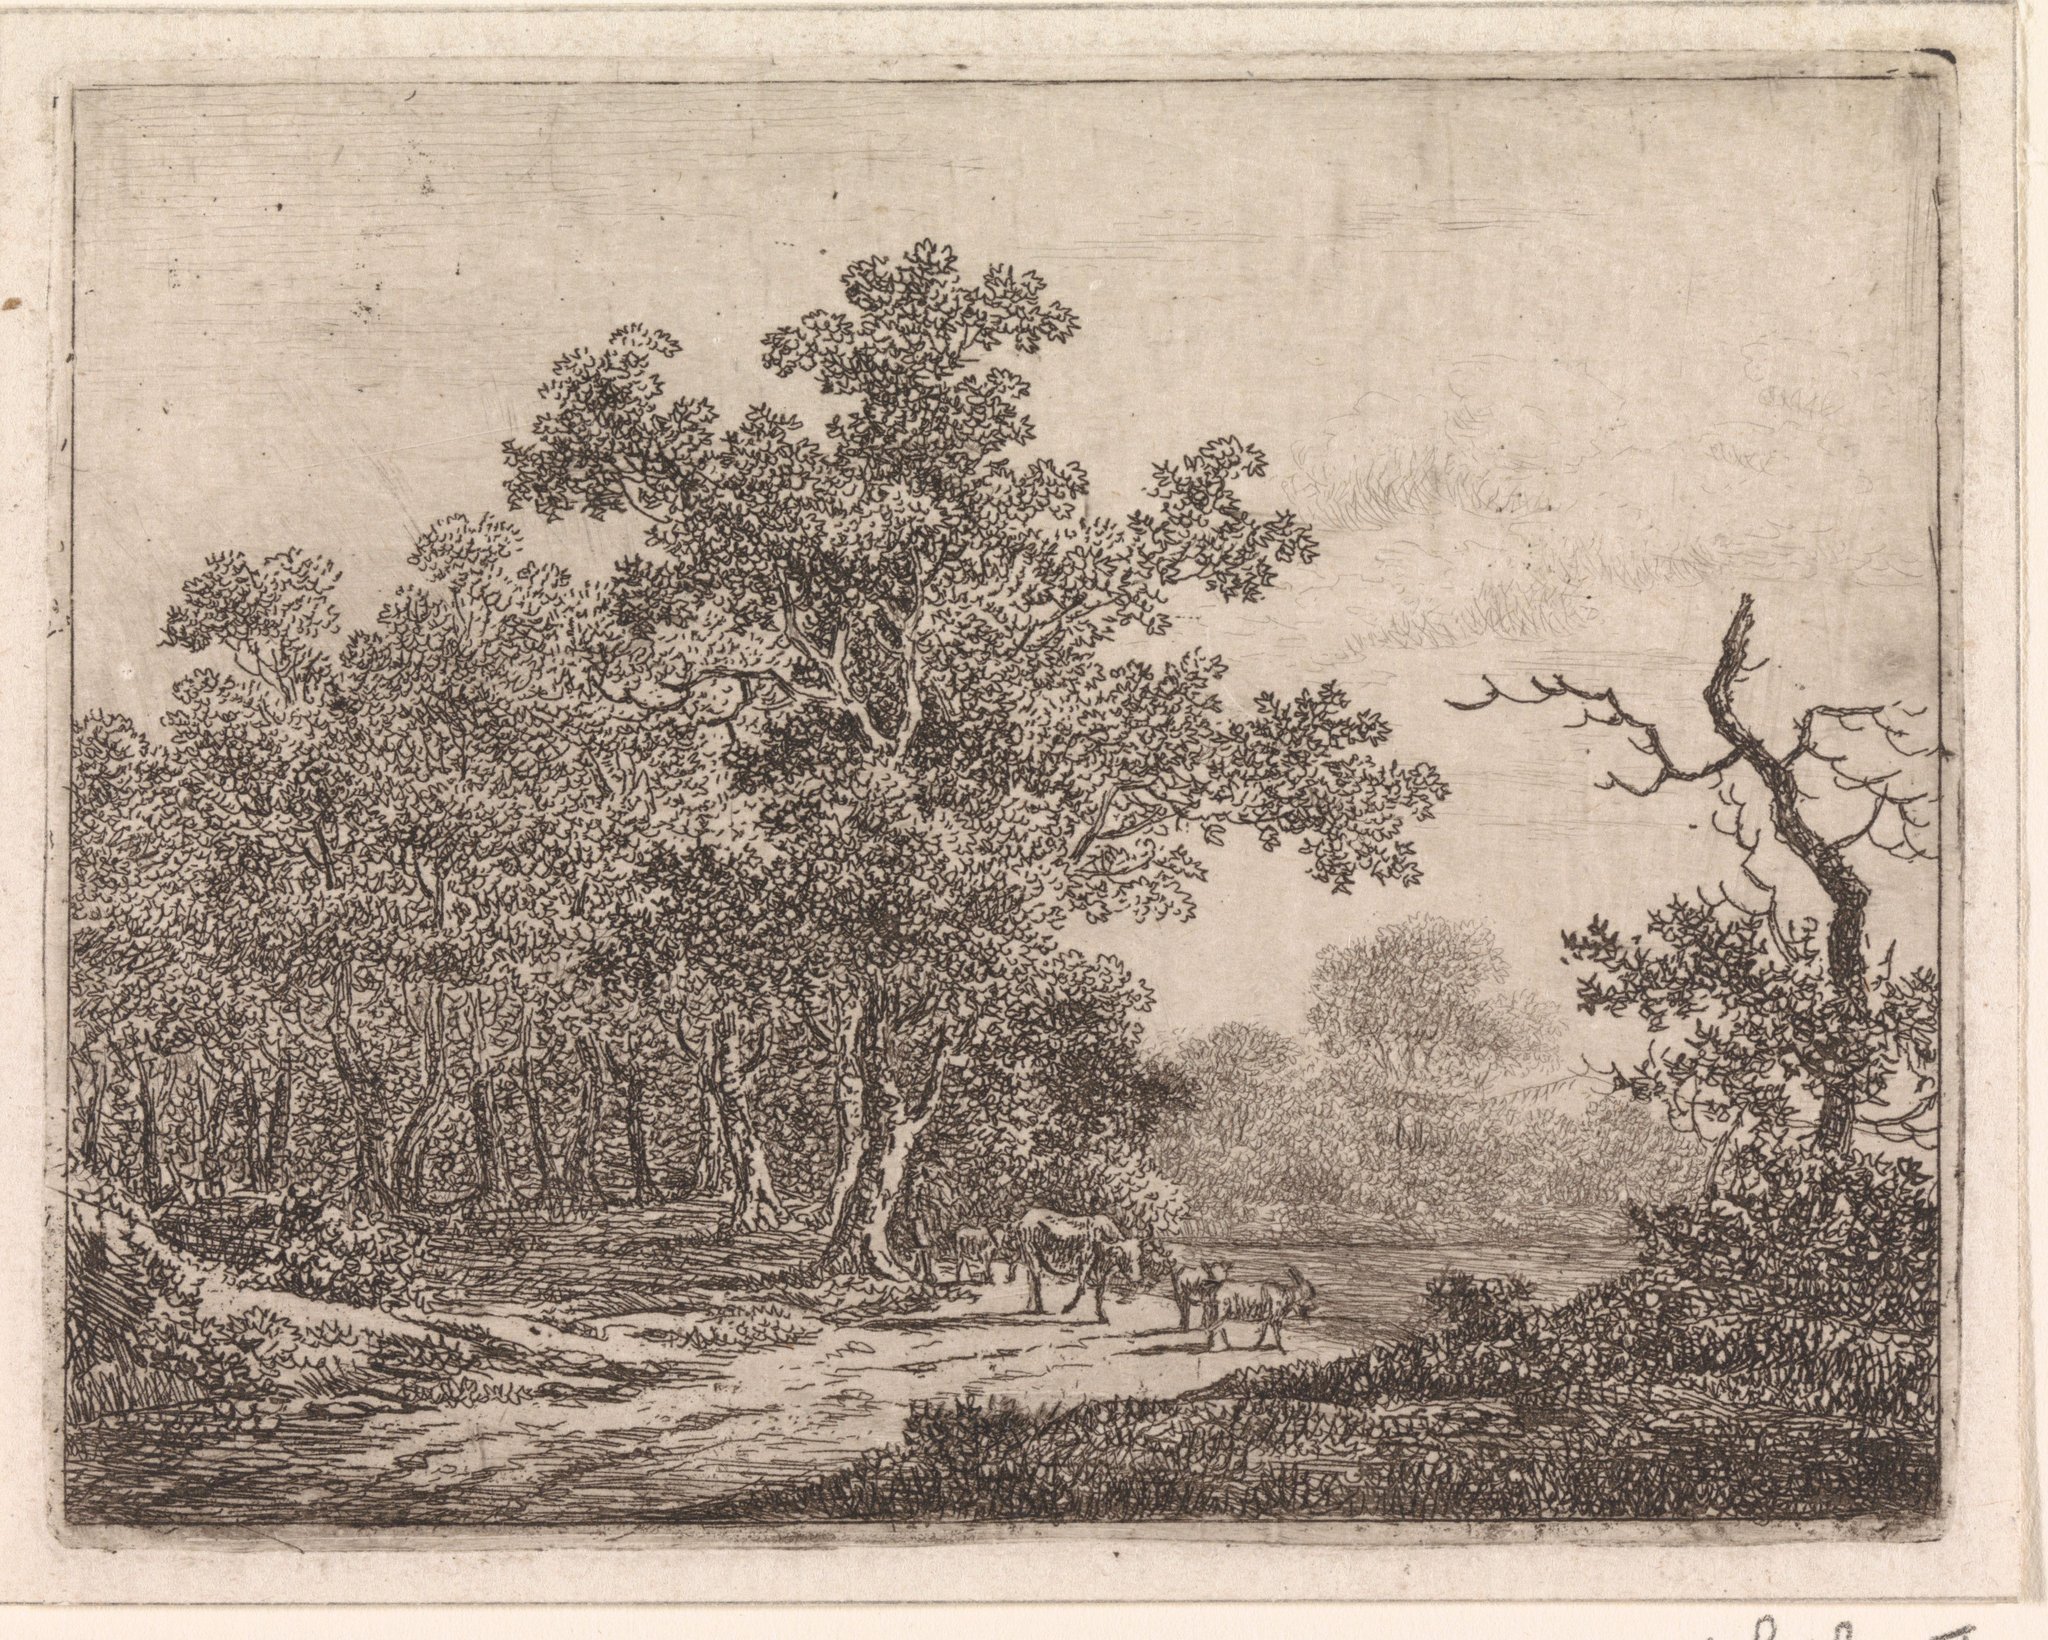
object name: print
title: Landschap met eik en vee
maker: johannes christiaan janson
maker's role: draughtsman, painter, print maker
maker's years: 1763-1823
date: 1778-1823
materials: paper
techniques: etching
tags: cow, sheep, landscapes (+ landscape with figures, staffage)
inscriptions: collector's mark: Lugt 2228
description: Landschap met eik en een herder. De herder drijf zijn koe, twee schapen en geit over een pad naar het water. Rechts op de voorgrond een kale boom. Meer bewerkt dan vorige staat.